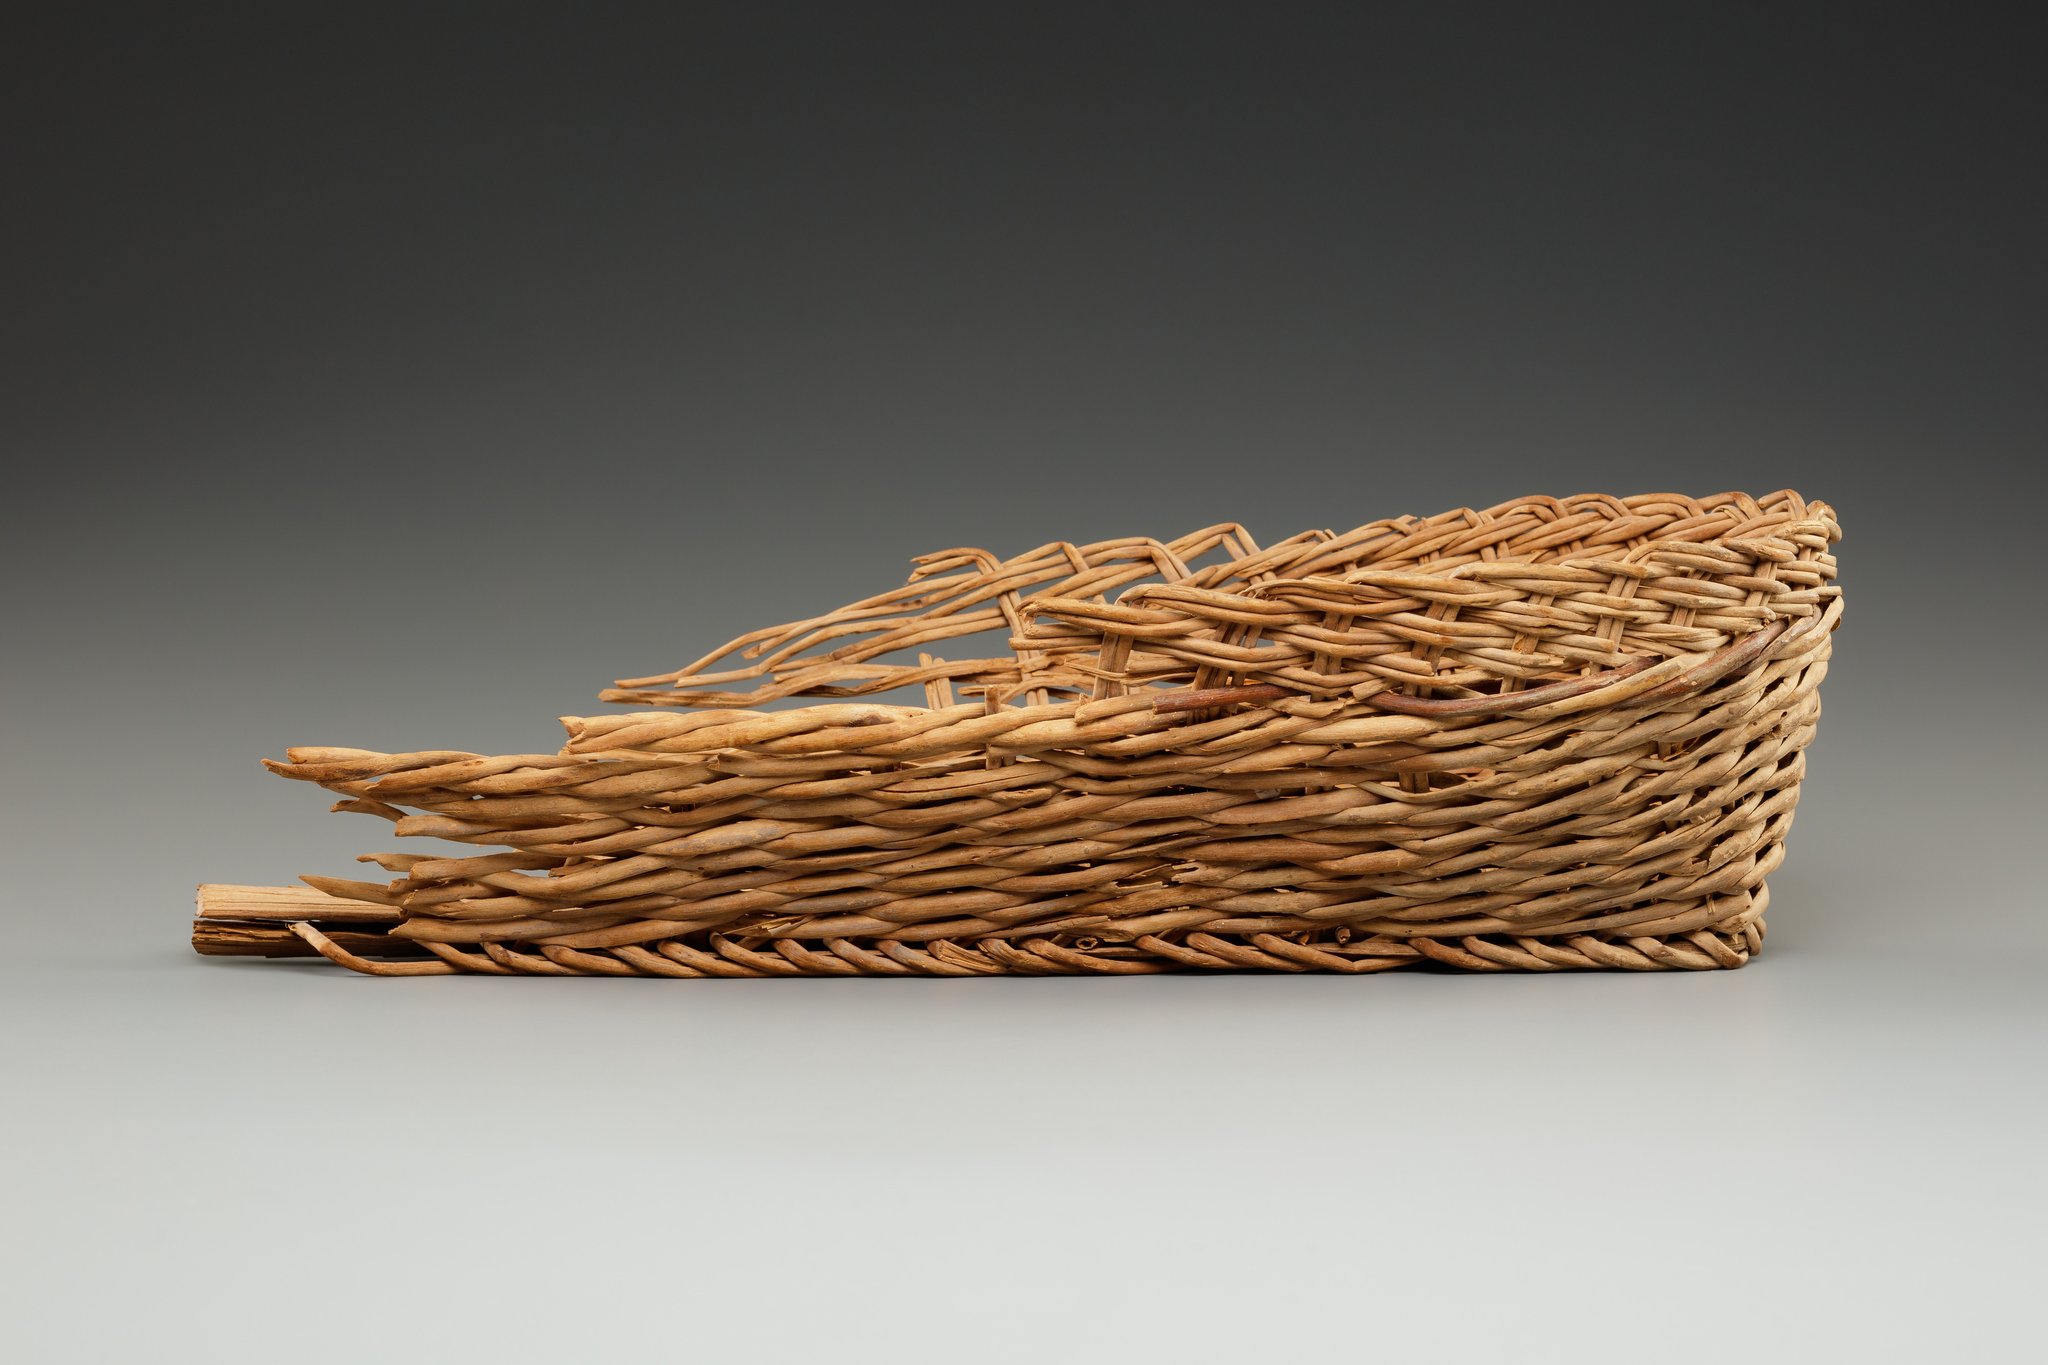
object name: basket, 3 bottle found inside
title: Lid of basket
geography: middle egypt